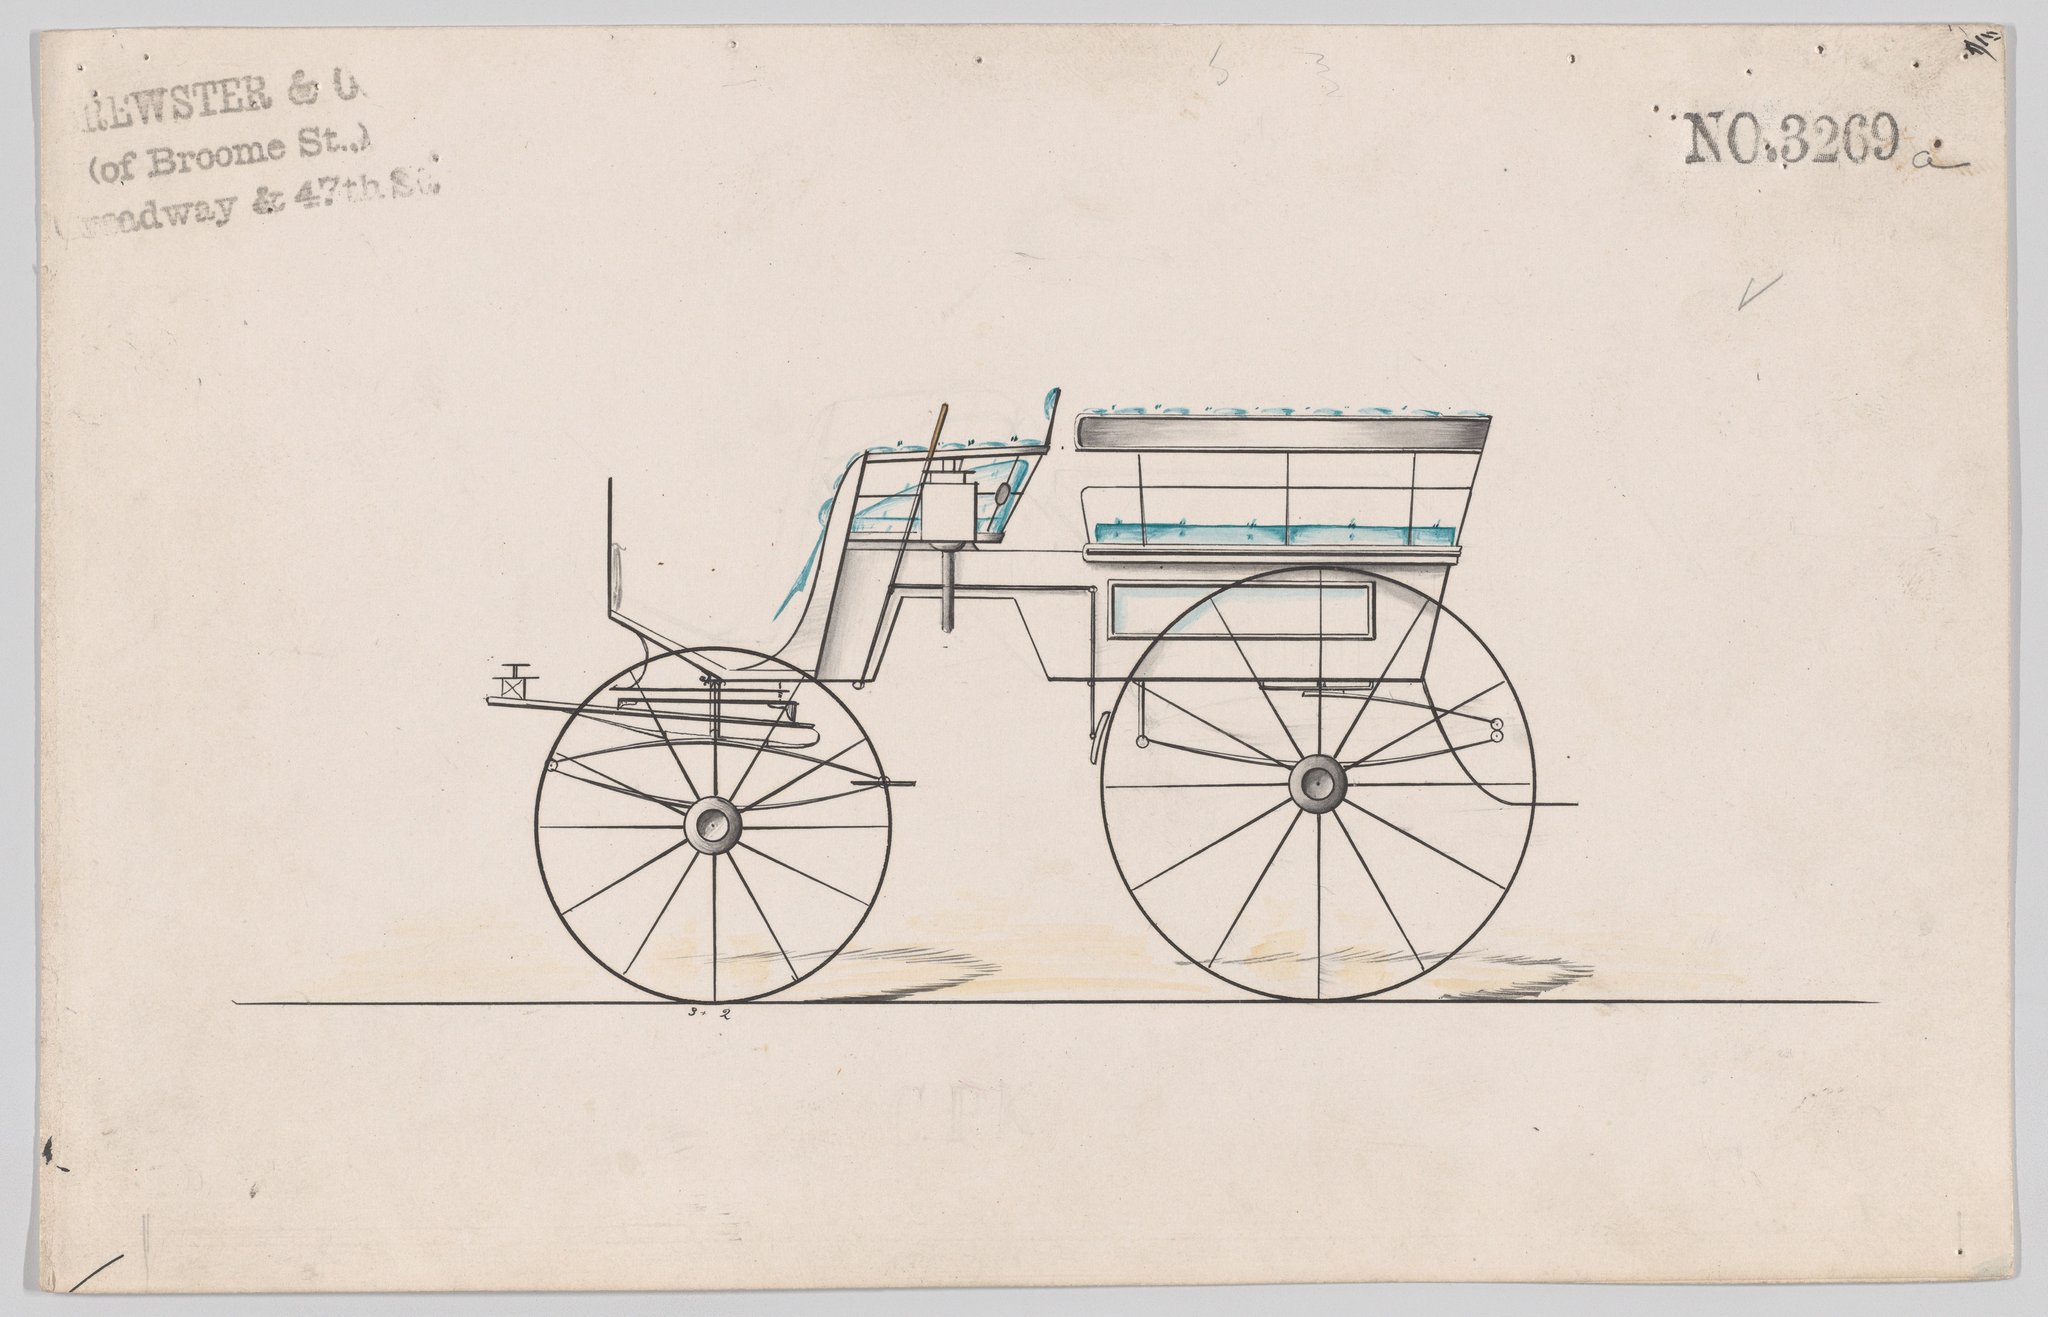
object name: drawing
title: Design for Omnibus or Wagonette, no. 3269a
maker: brewster & co.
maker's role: manufacturer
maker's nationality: american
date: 1876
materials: gouache, ink, watercolor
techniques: pen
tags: carriages